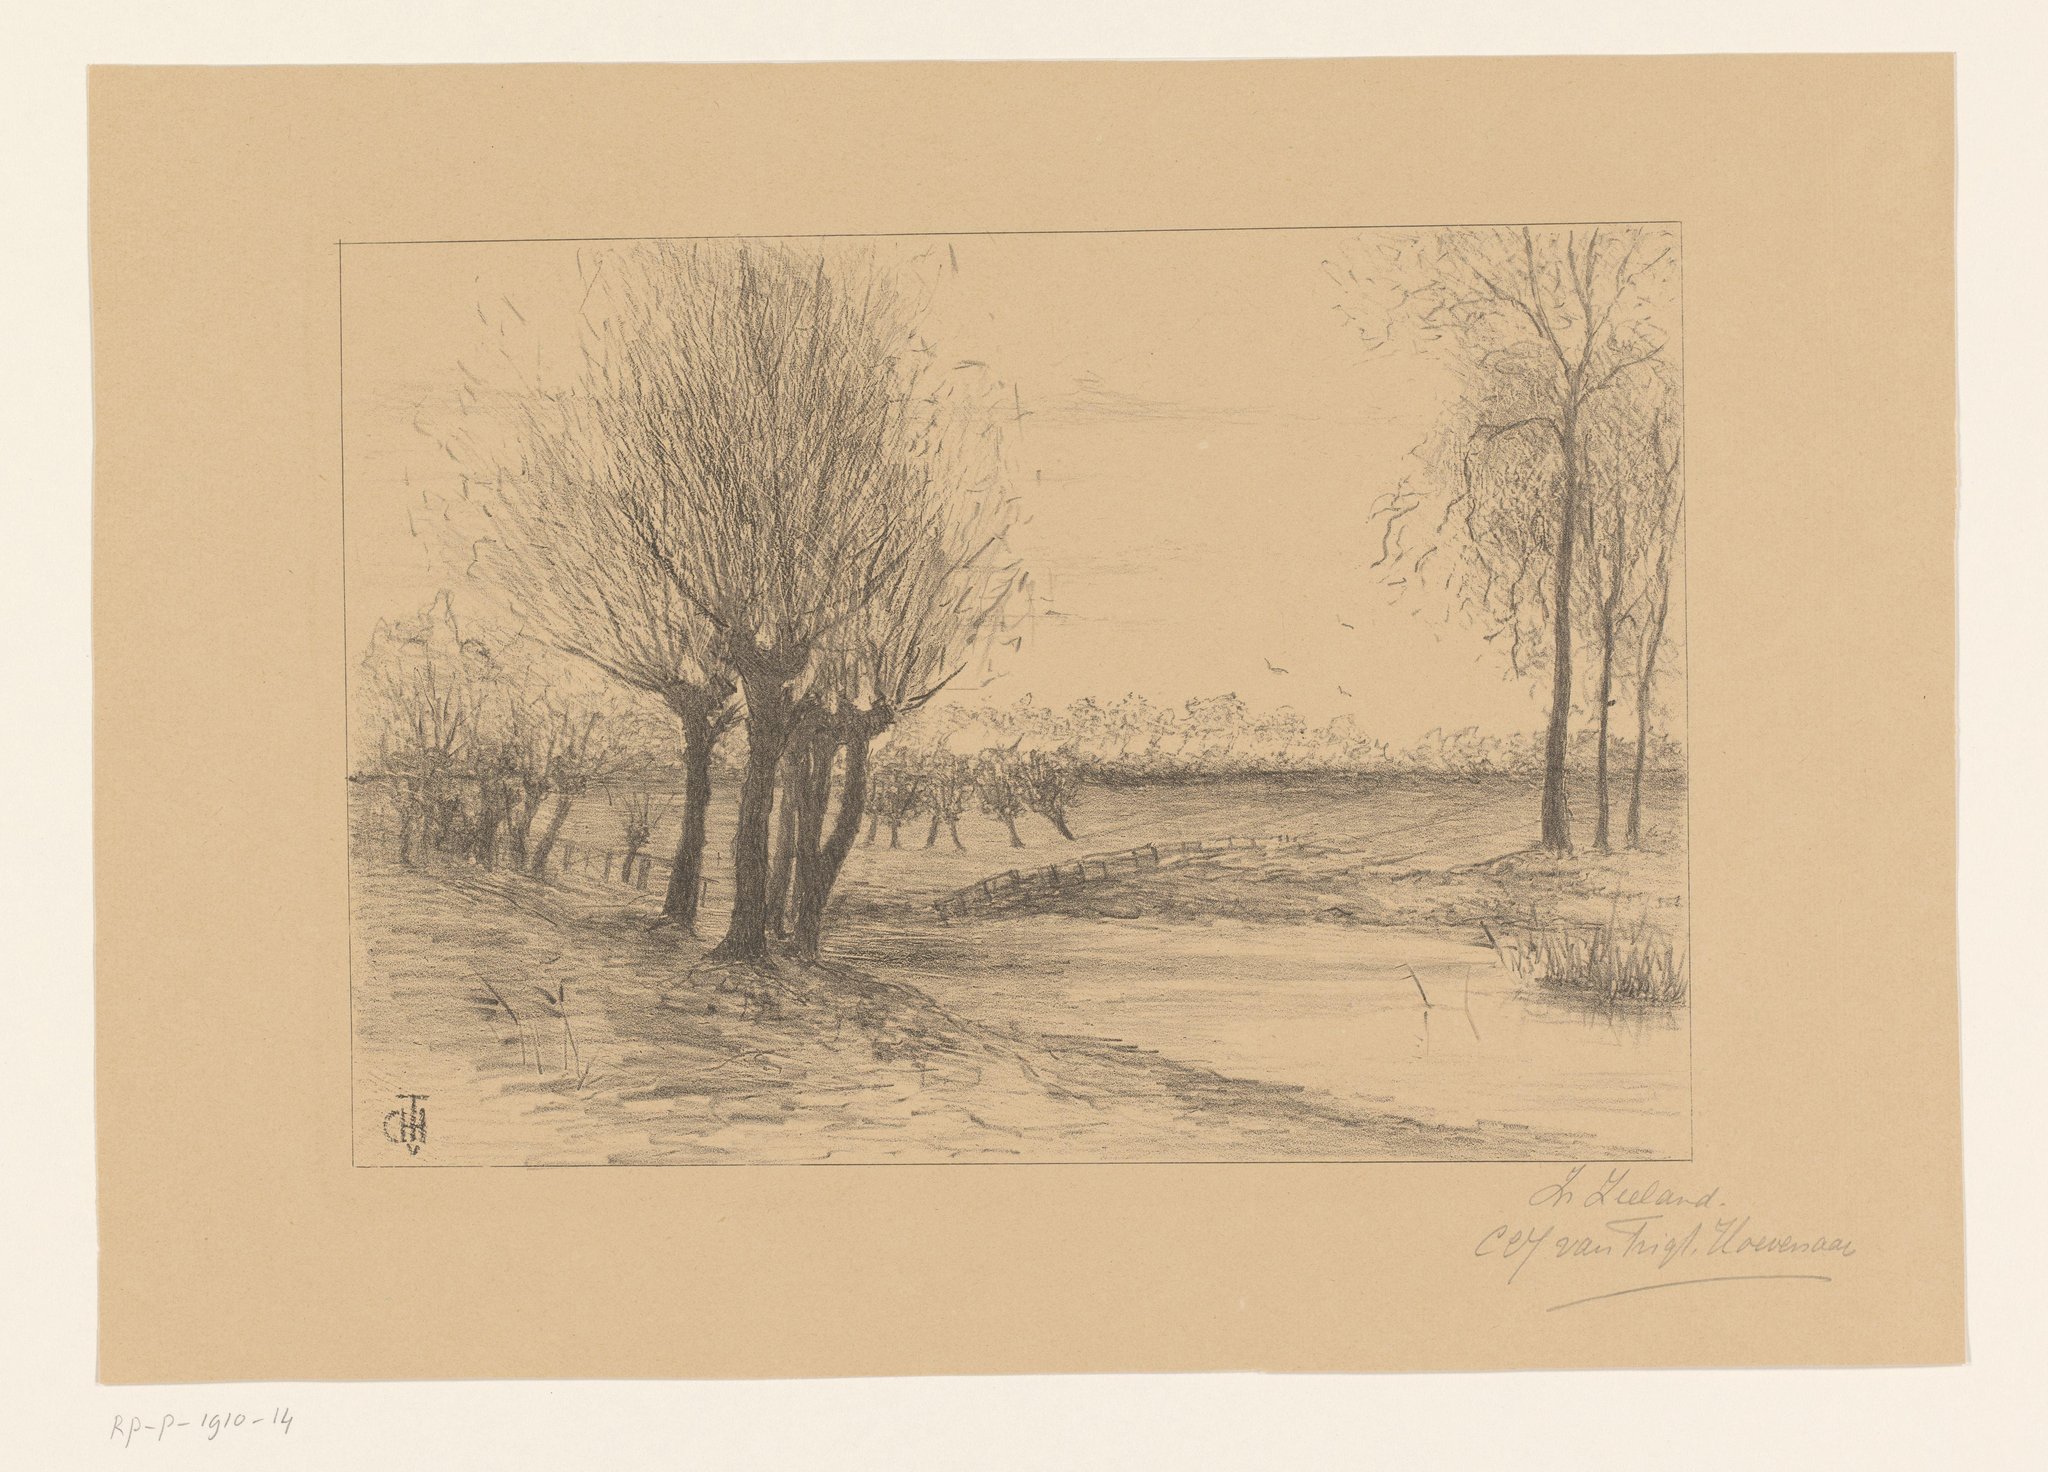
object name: print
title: In Zeeland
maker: cornelia christina johanna van trigt-hoevenaar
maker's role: print maker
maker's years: 1854-1924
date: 1864-1910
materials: paper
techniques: lithograph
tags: meadow, pasture, pond, pool, trees: willow, zeeland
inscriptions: collector's mark: Lugt 2228